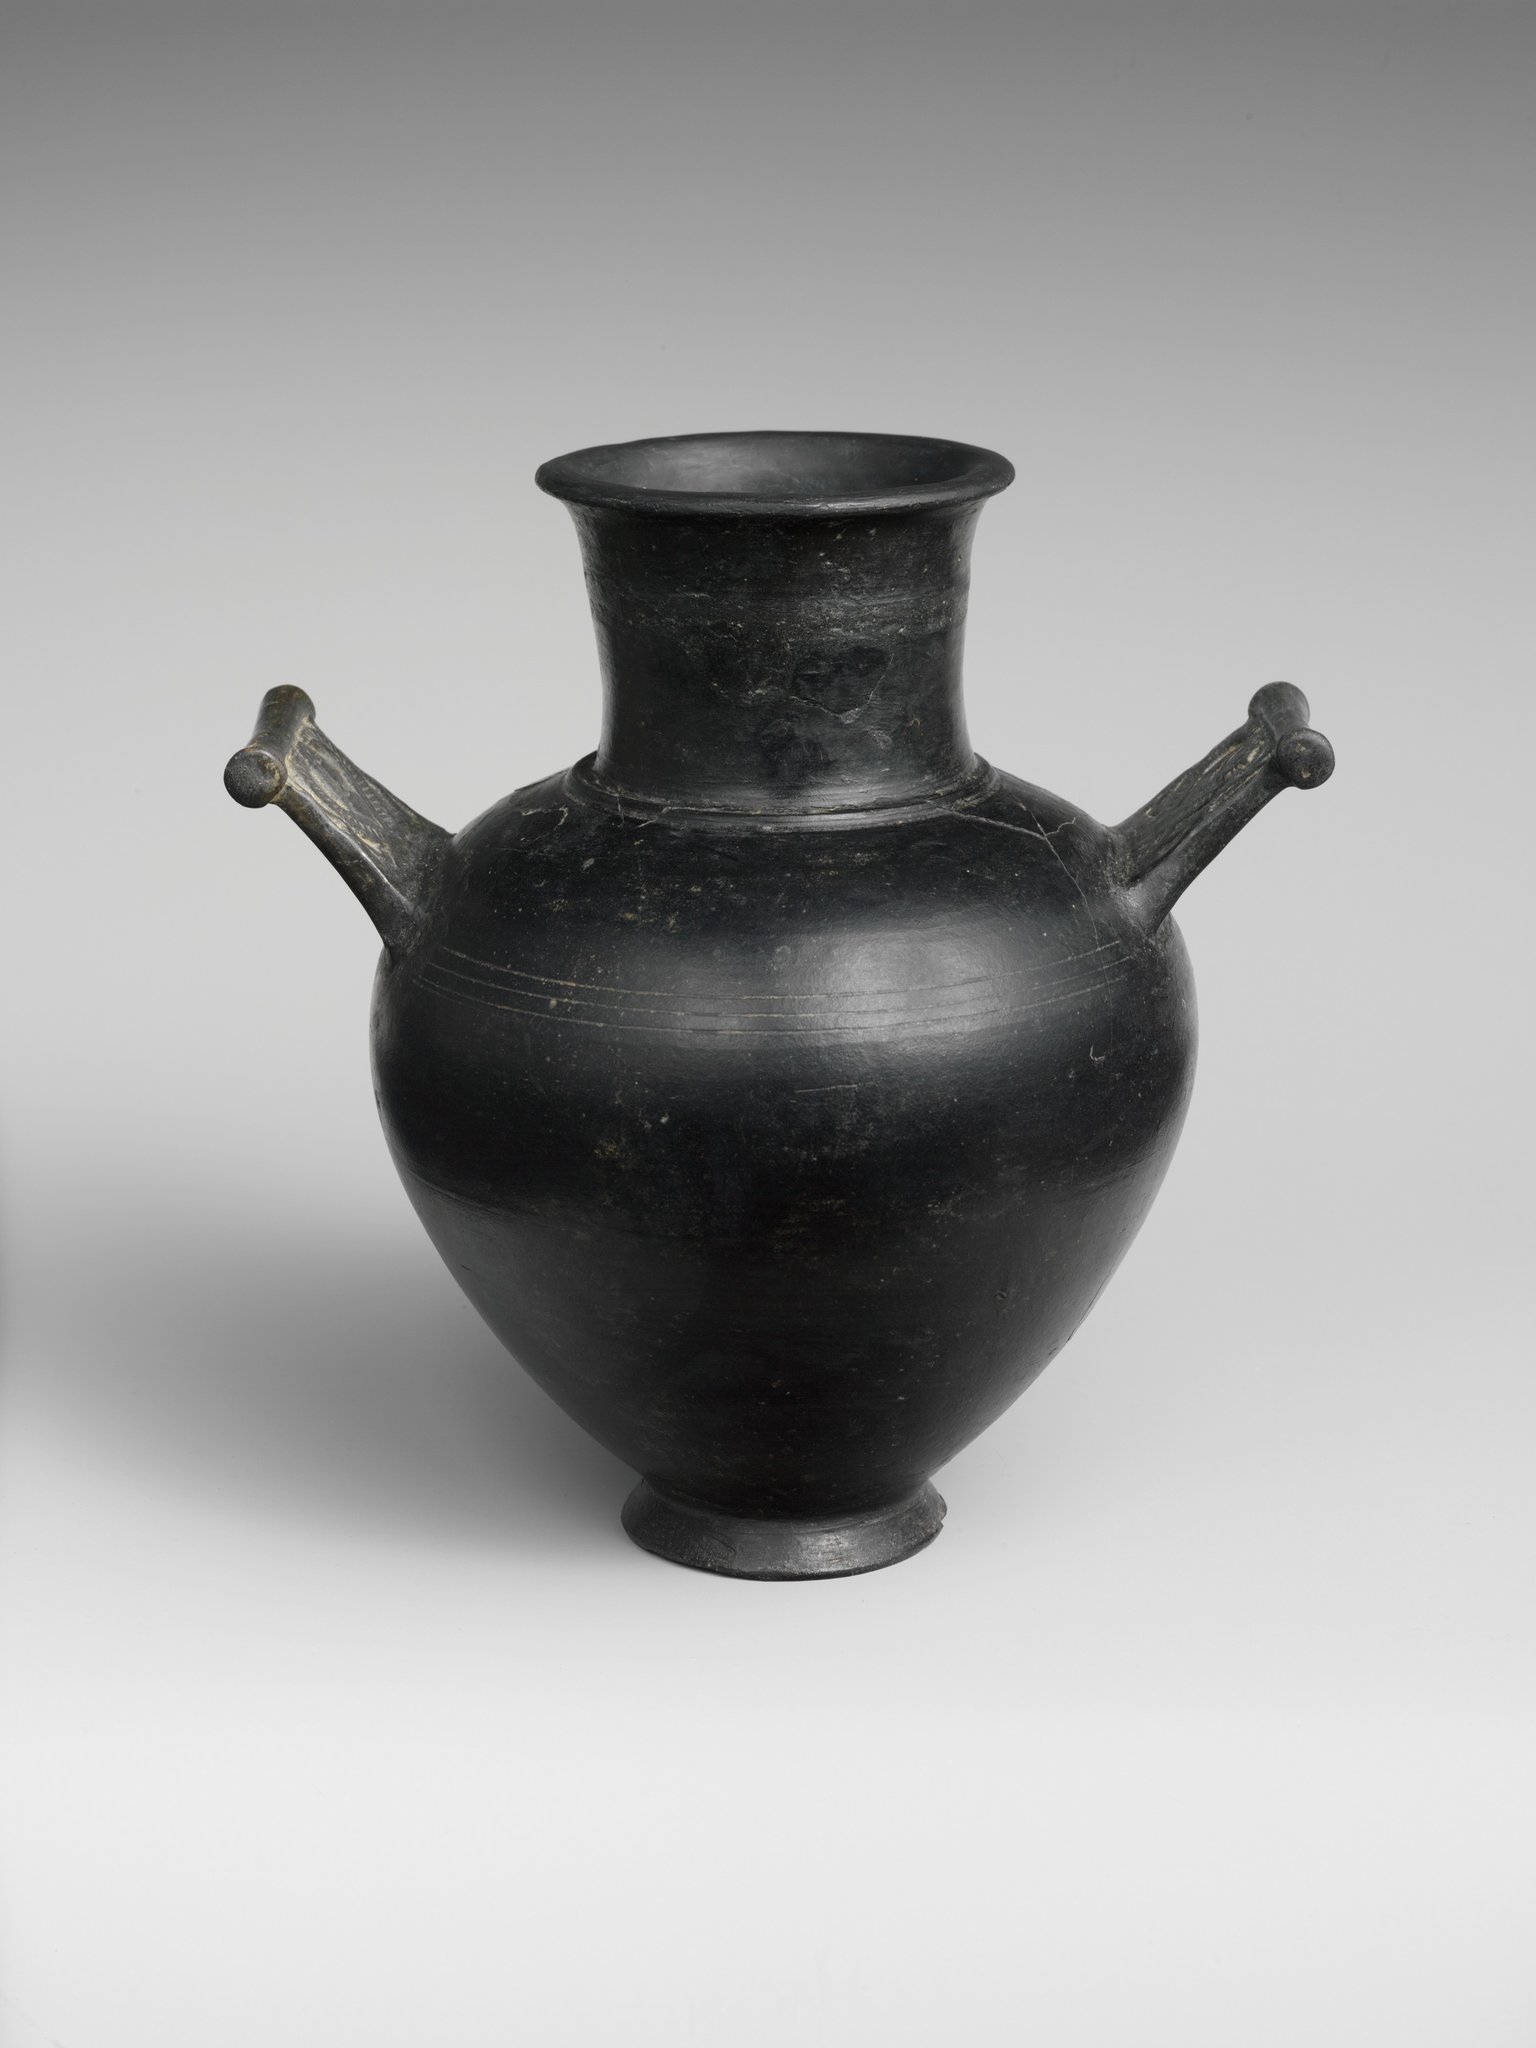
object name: vase with lid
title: Terracotta amphora with lid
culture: etruscan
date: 650-600 BCE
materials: terracotta